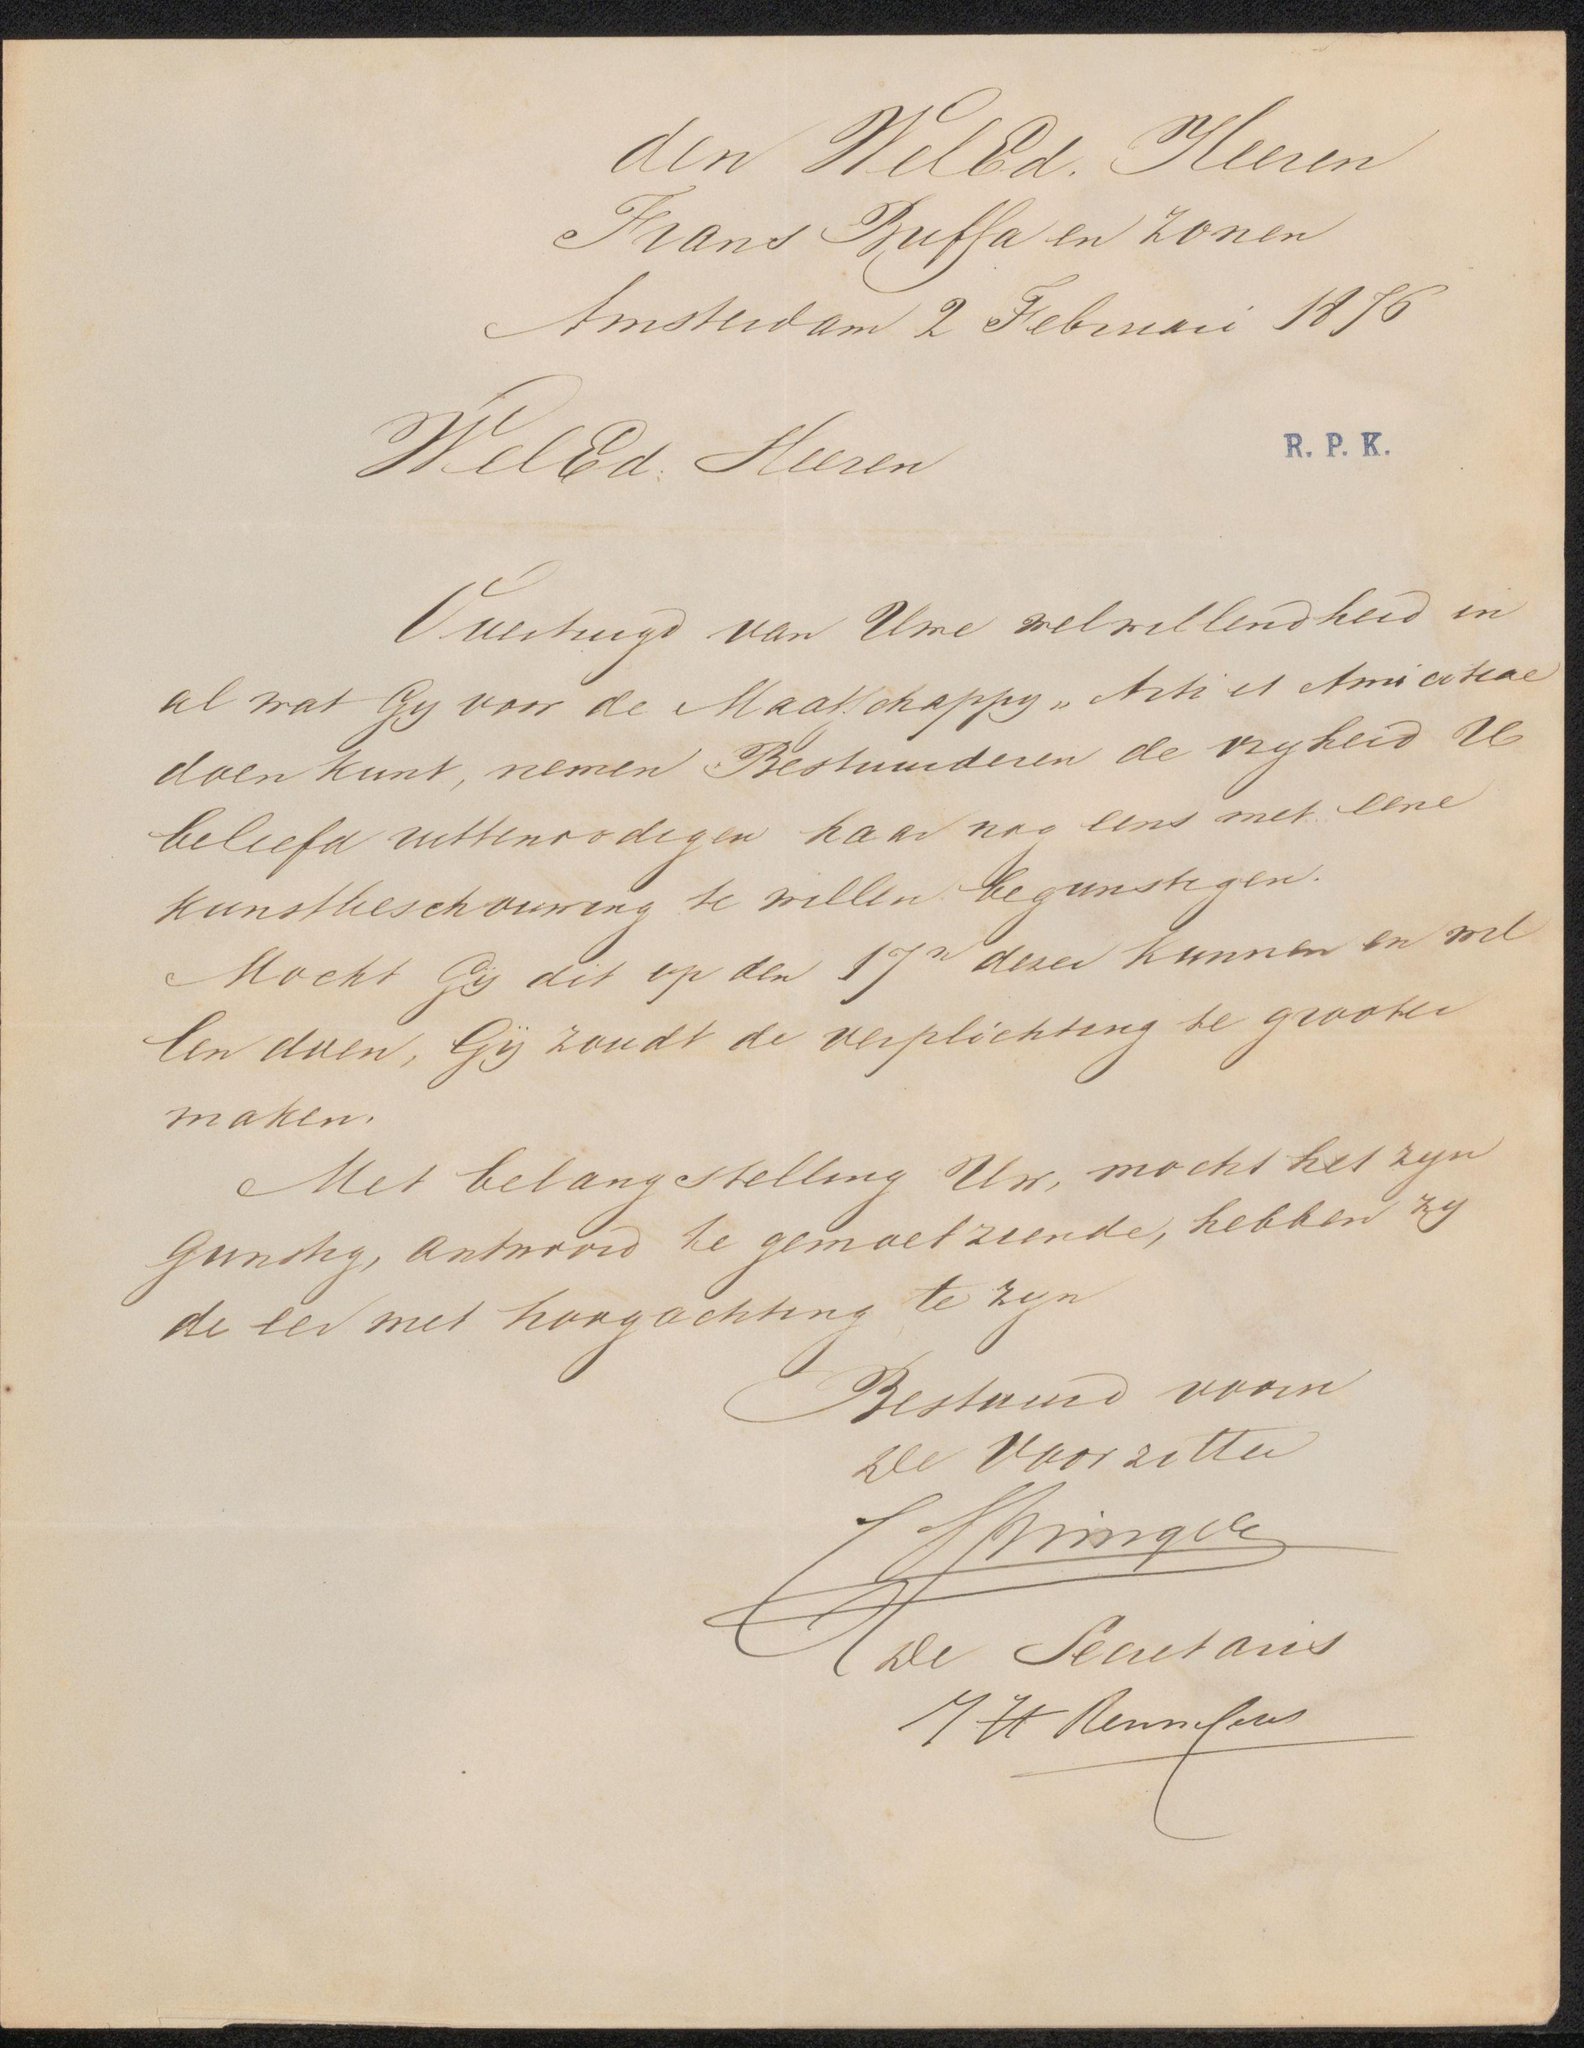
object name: letter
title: Brief aan Frans Buffa en Zonen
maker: johann heinrich maria hubert rennefeld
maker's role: print maker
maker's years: 1832-1877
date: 1876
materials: ink, paper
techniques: pen, writing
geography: amsterdam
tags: publisher, criticizing and discussing art, art criticism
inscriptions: collector's mark: Lugt 2233